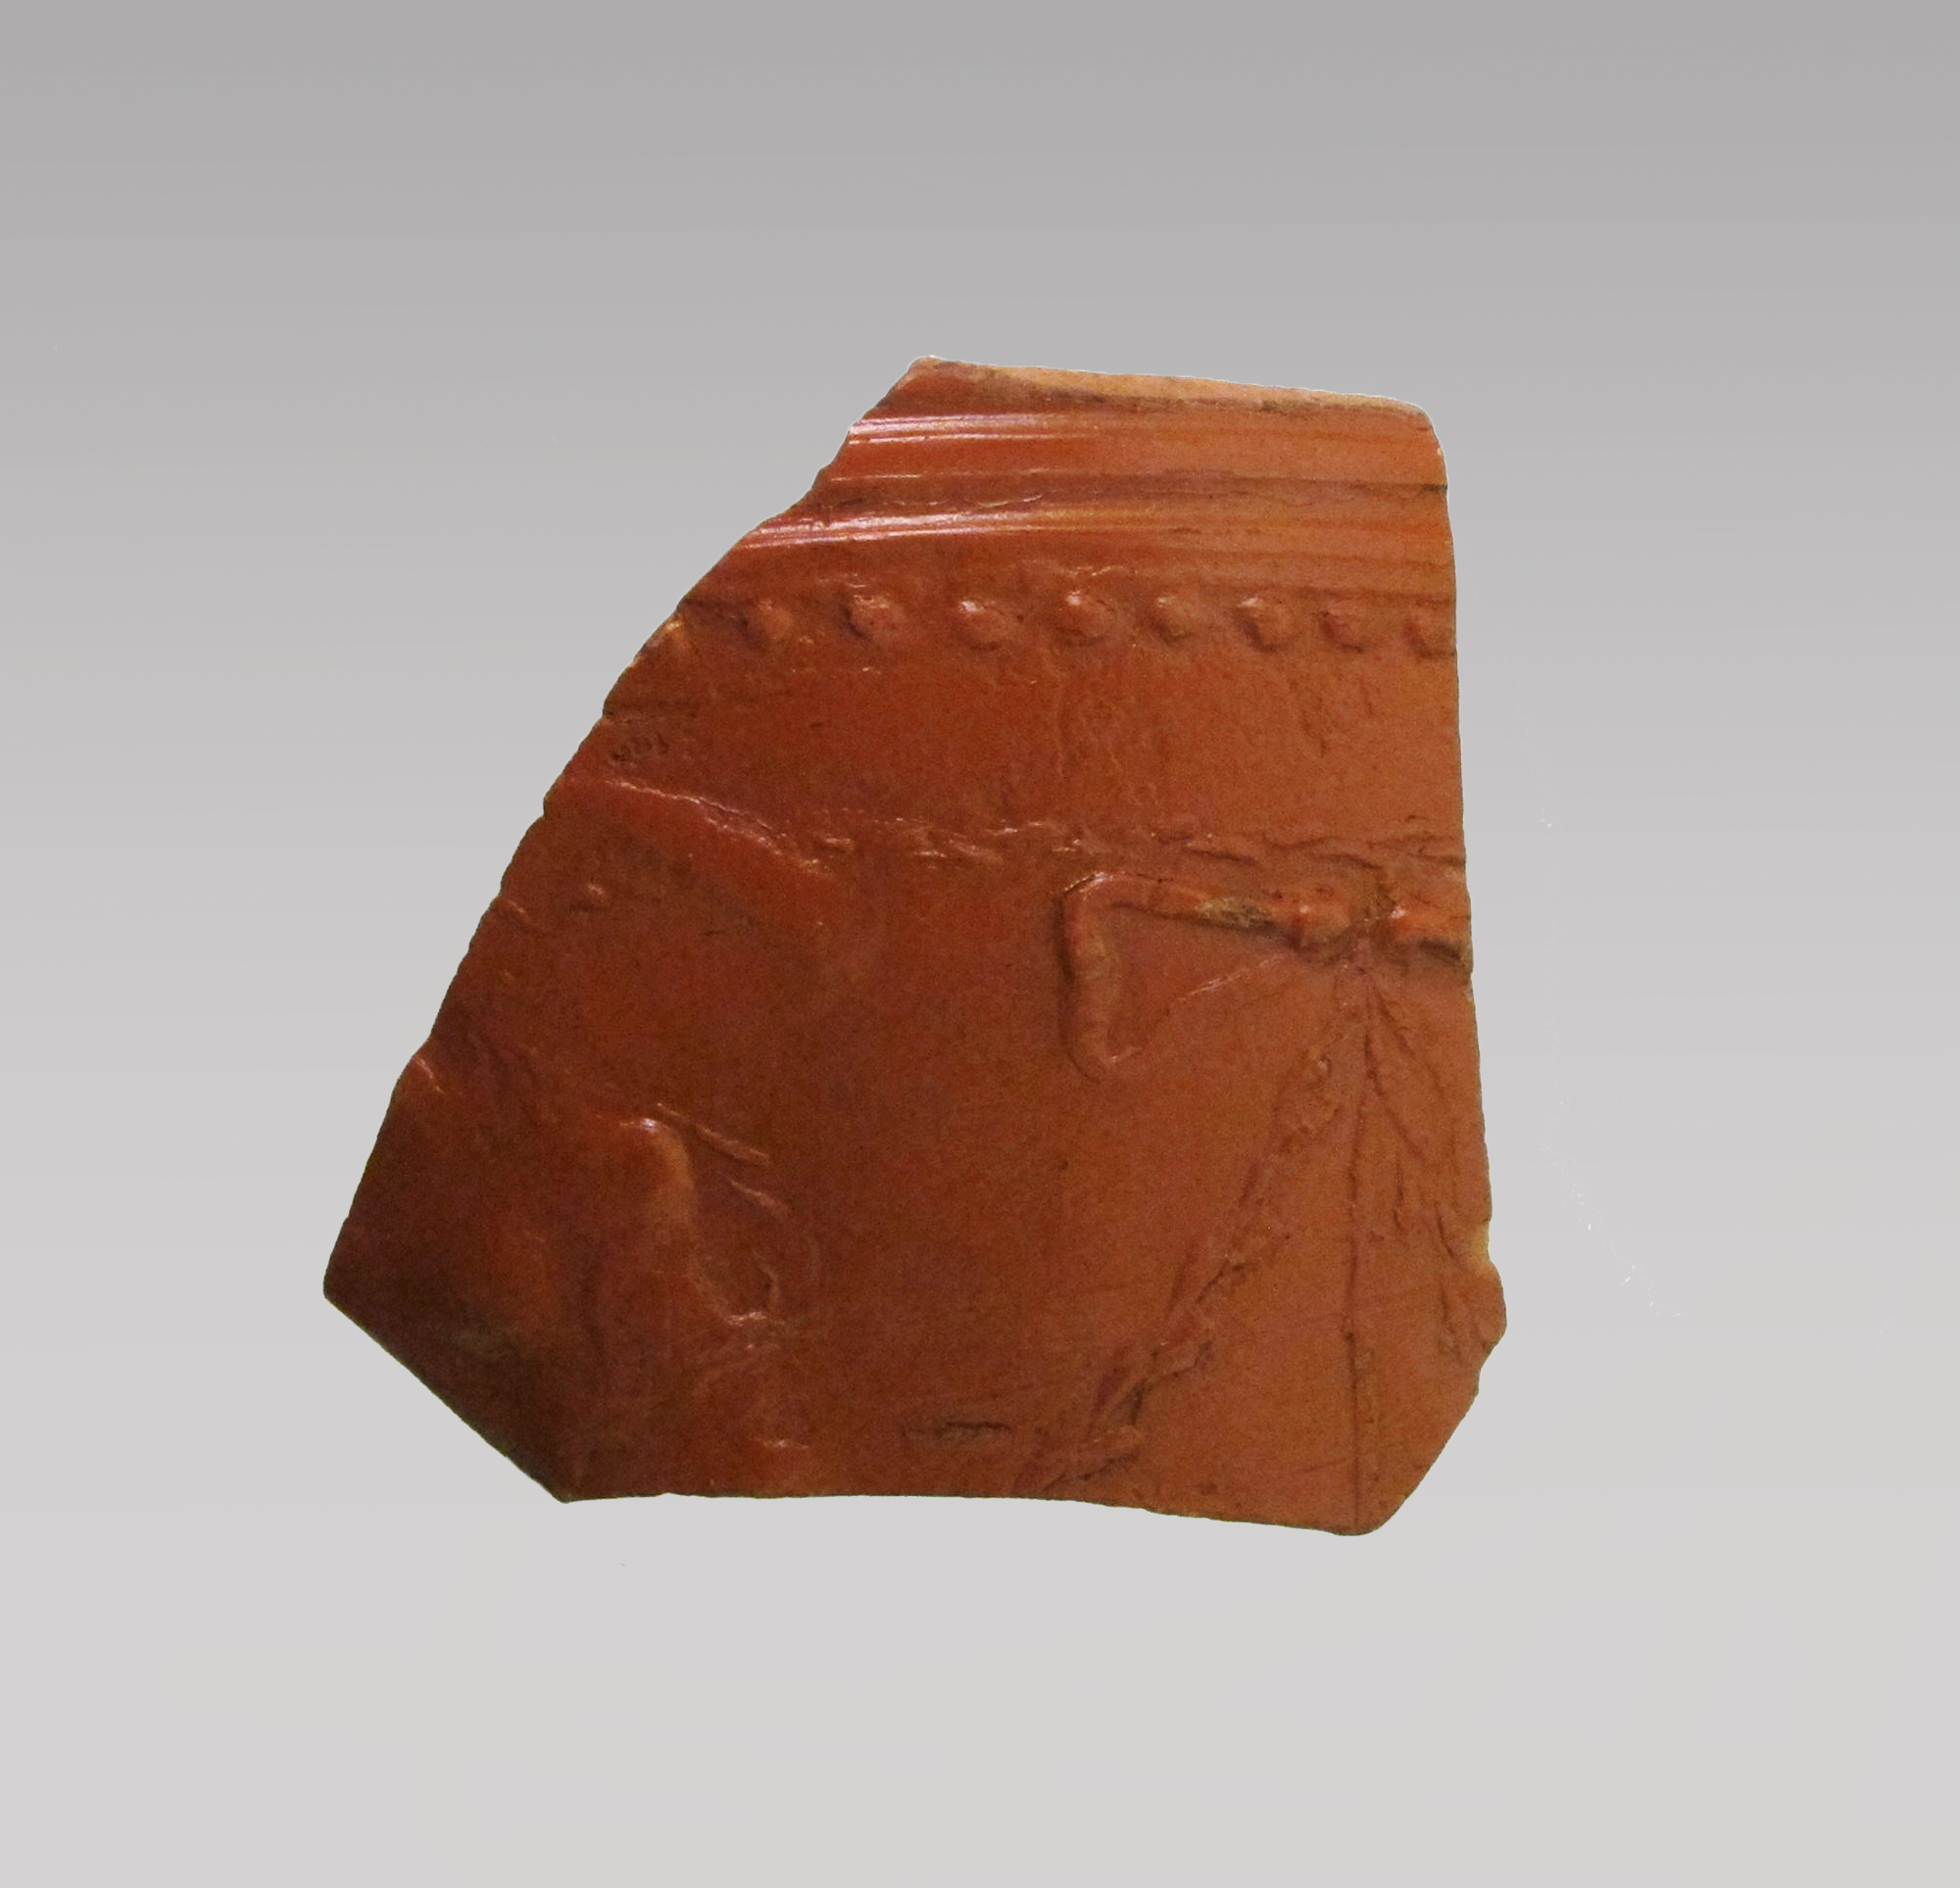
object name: vase fragment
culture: roman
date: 670 BCE-330 CE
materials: terracotta